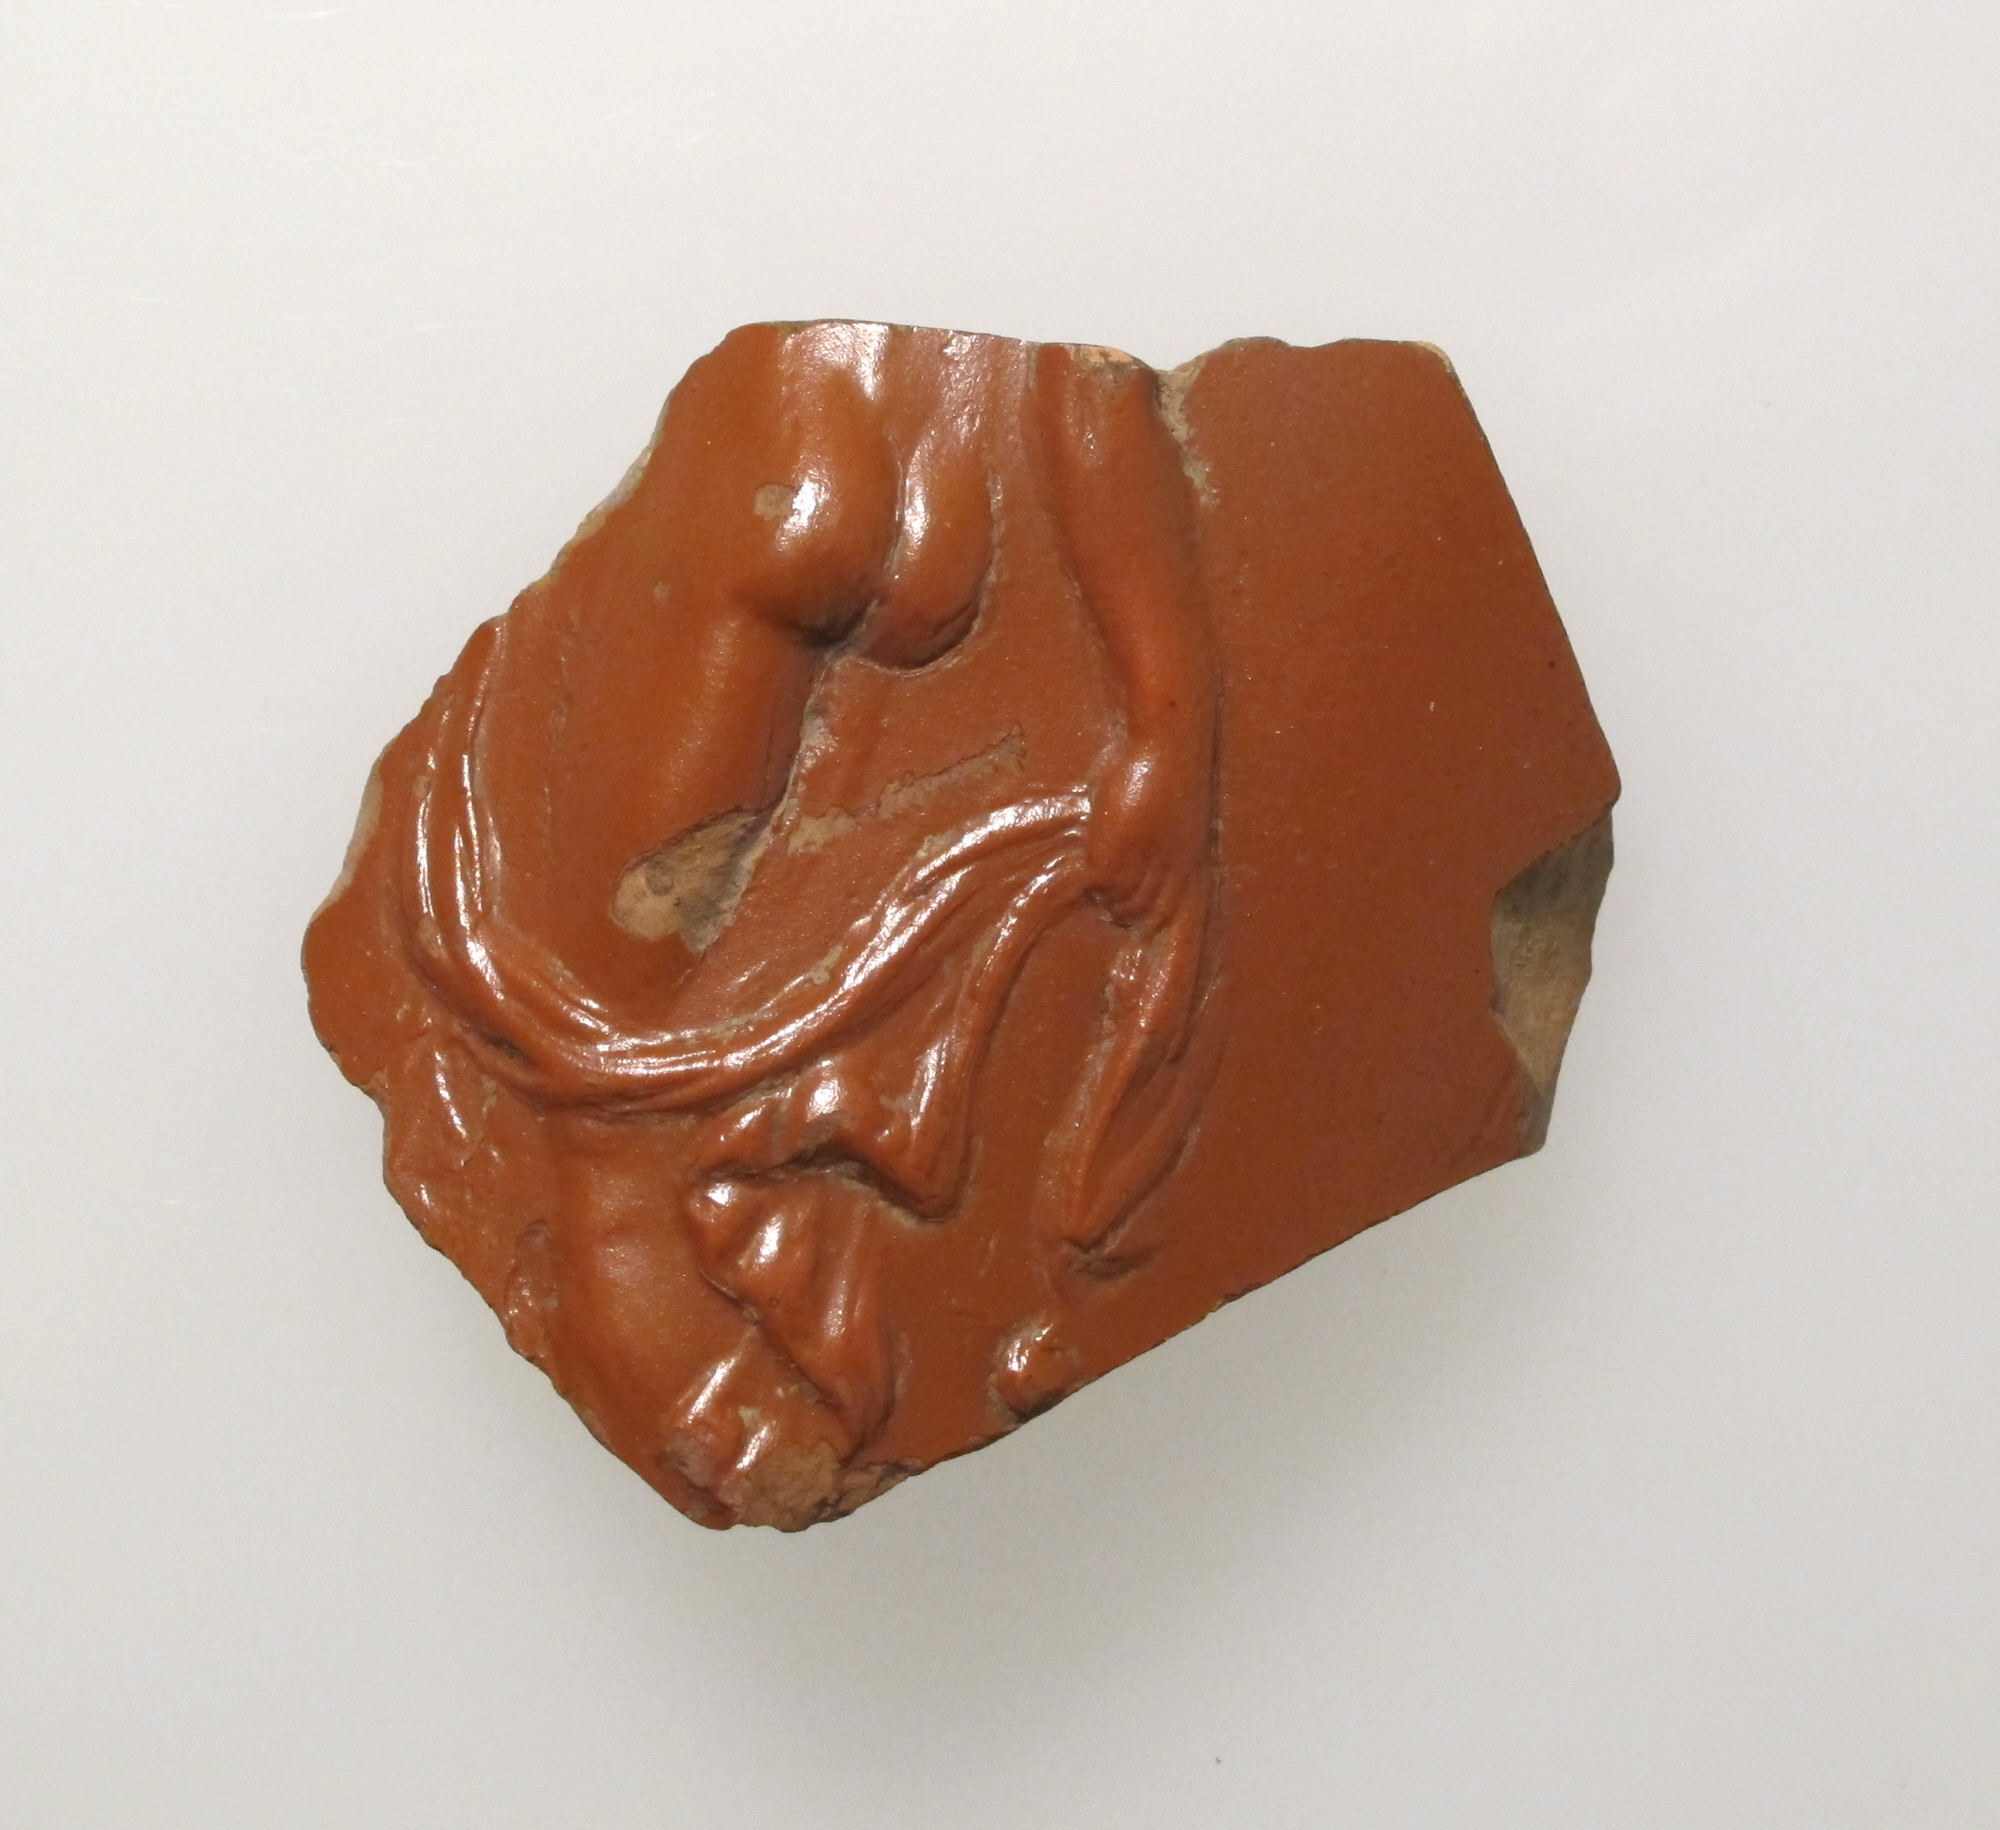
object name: vase fragment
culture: roman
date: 100 BCE-100 CE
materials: terracotta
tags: female nudes